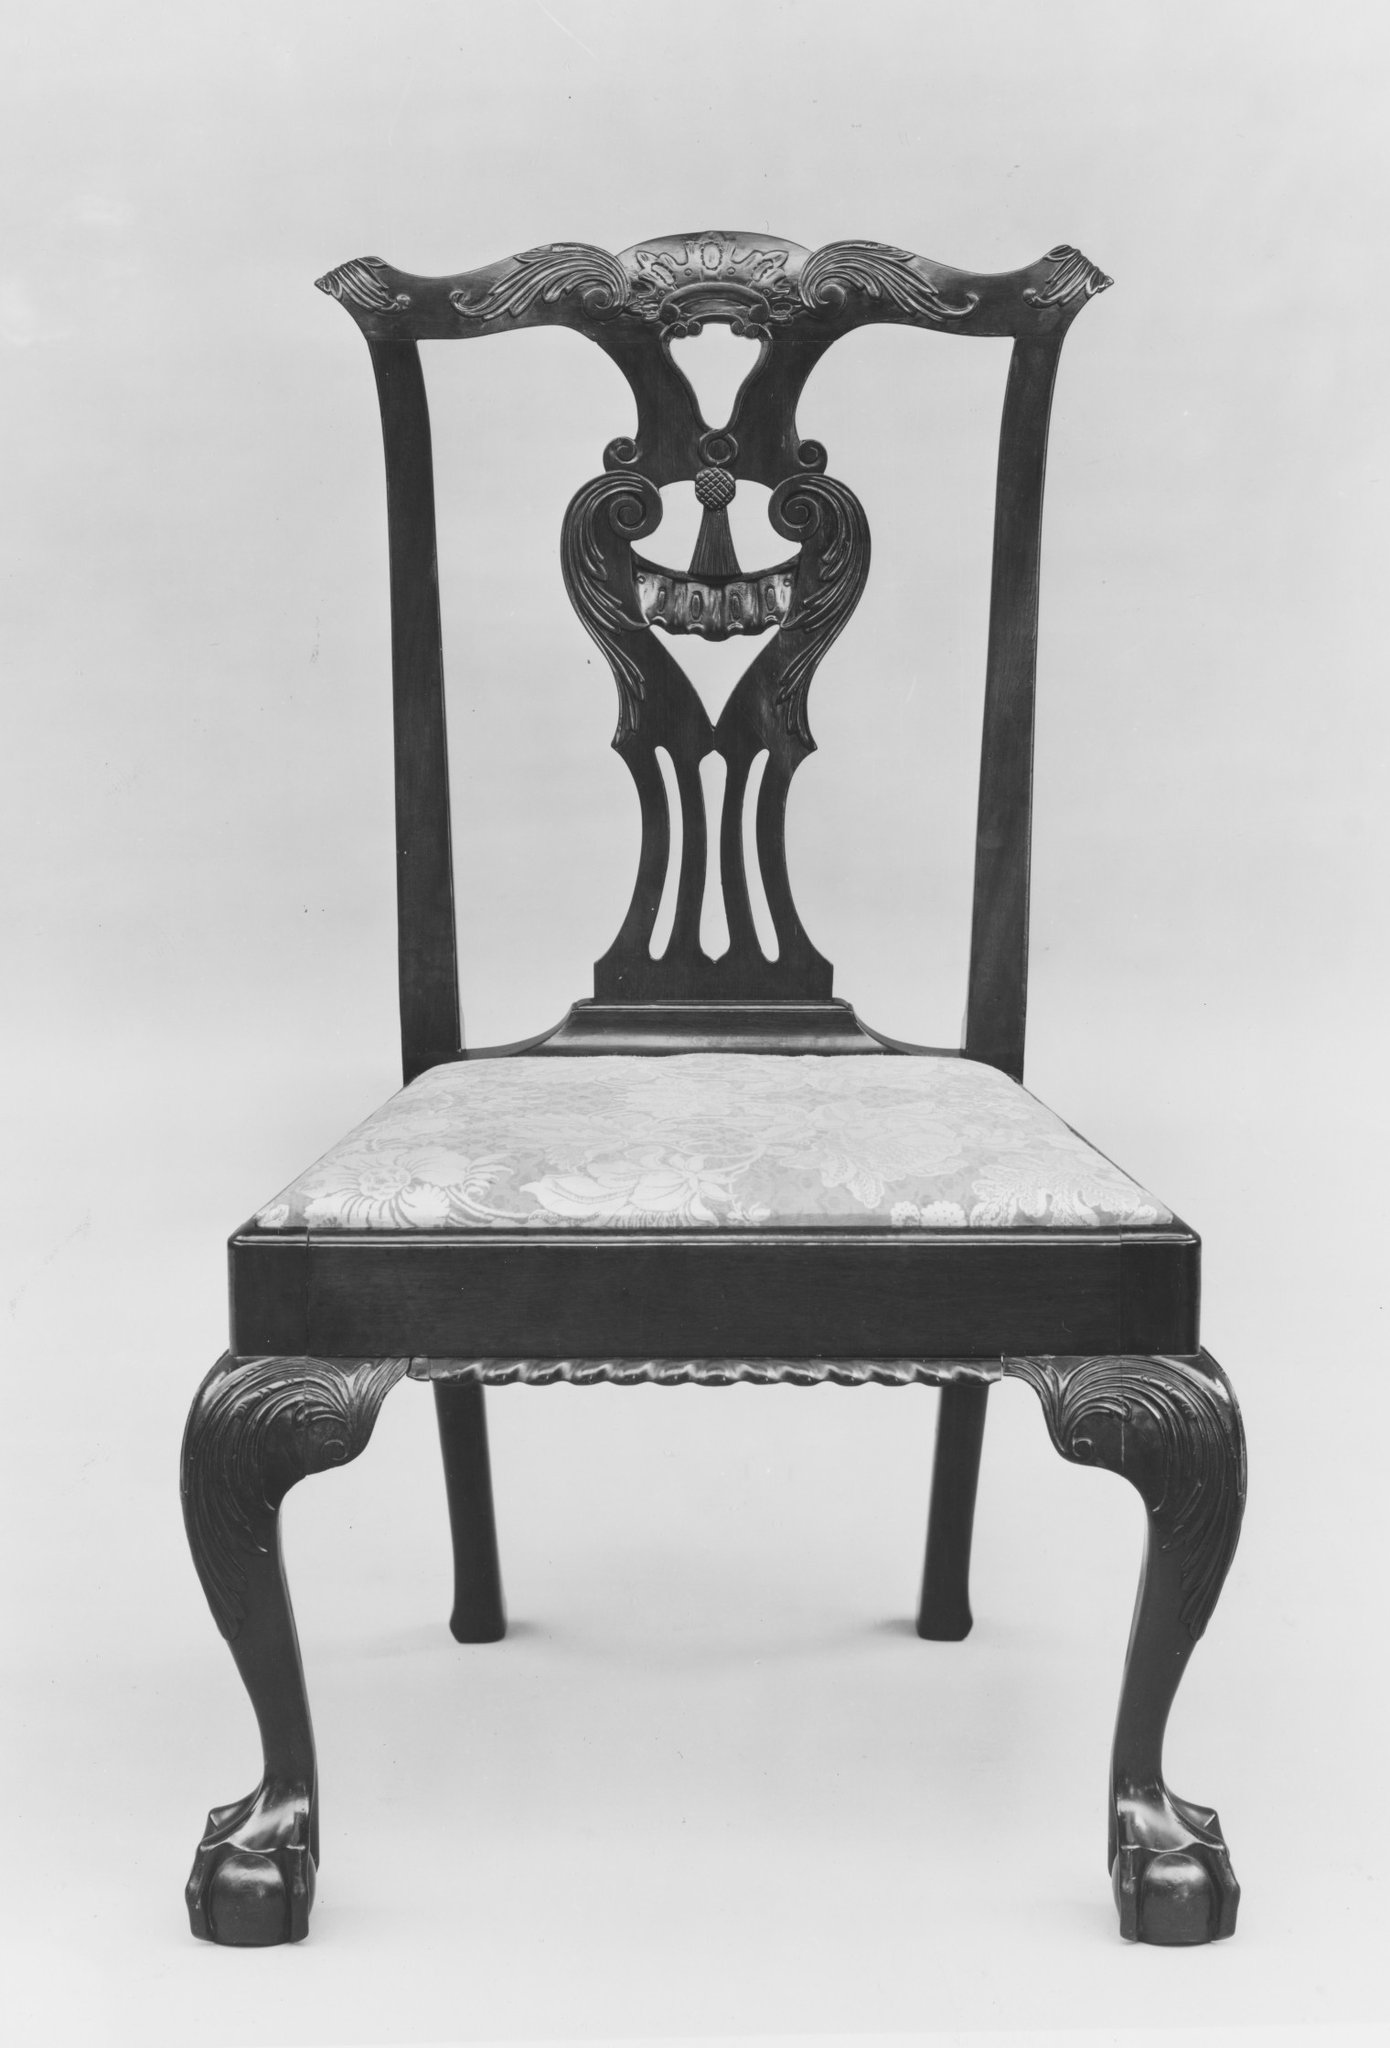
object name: side chair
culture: american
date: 1755-1790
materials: wood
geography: united states